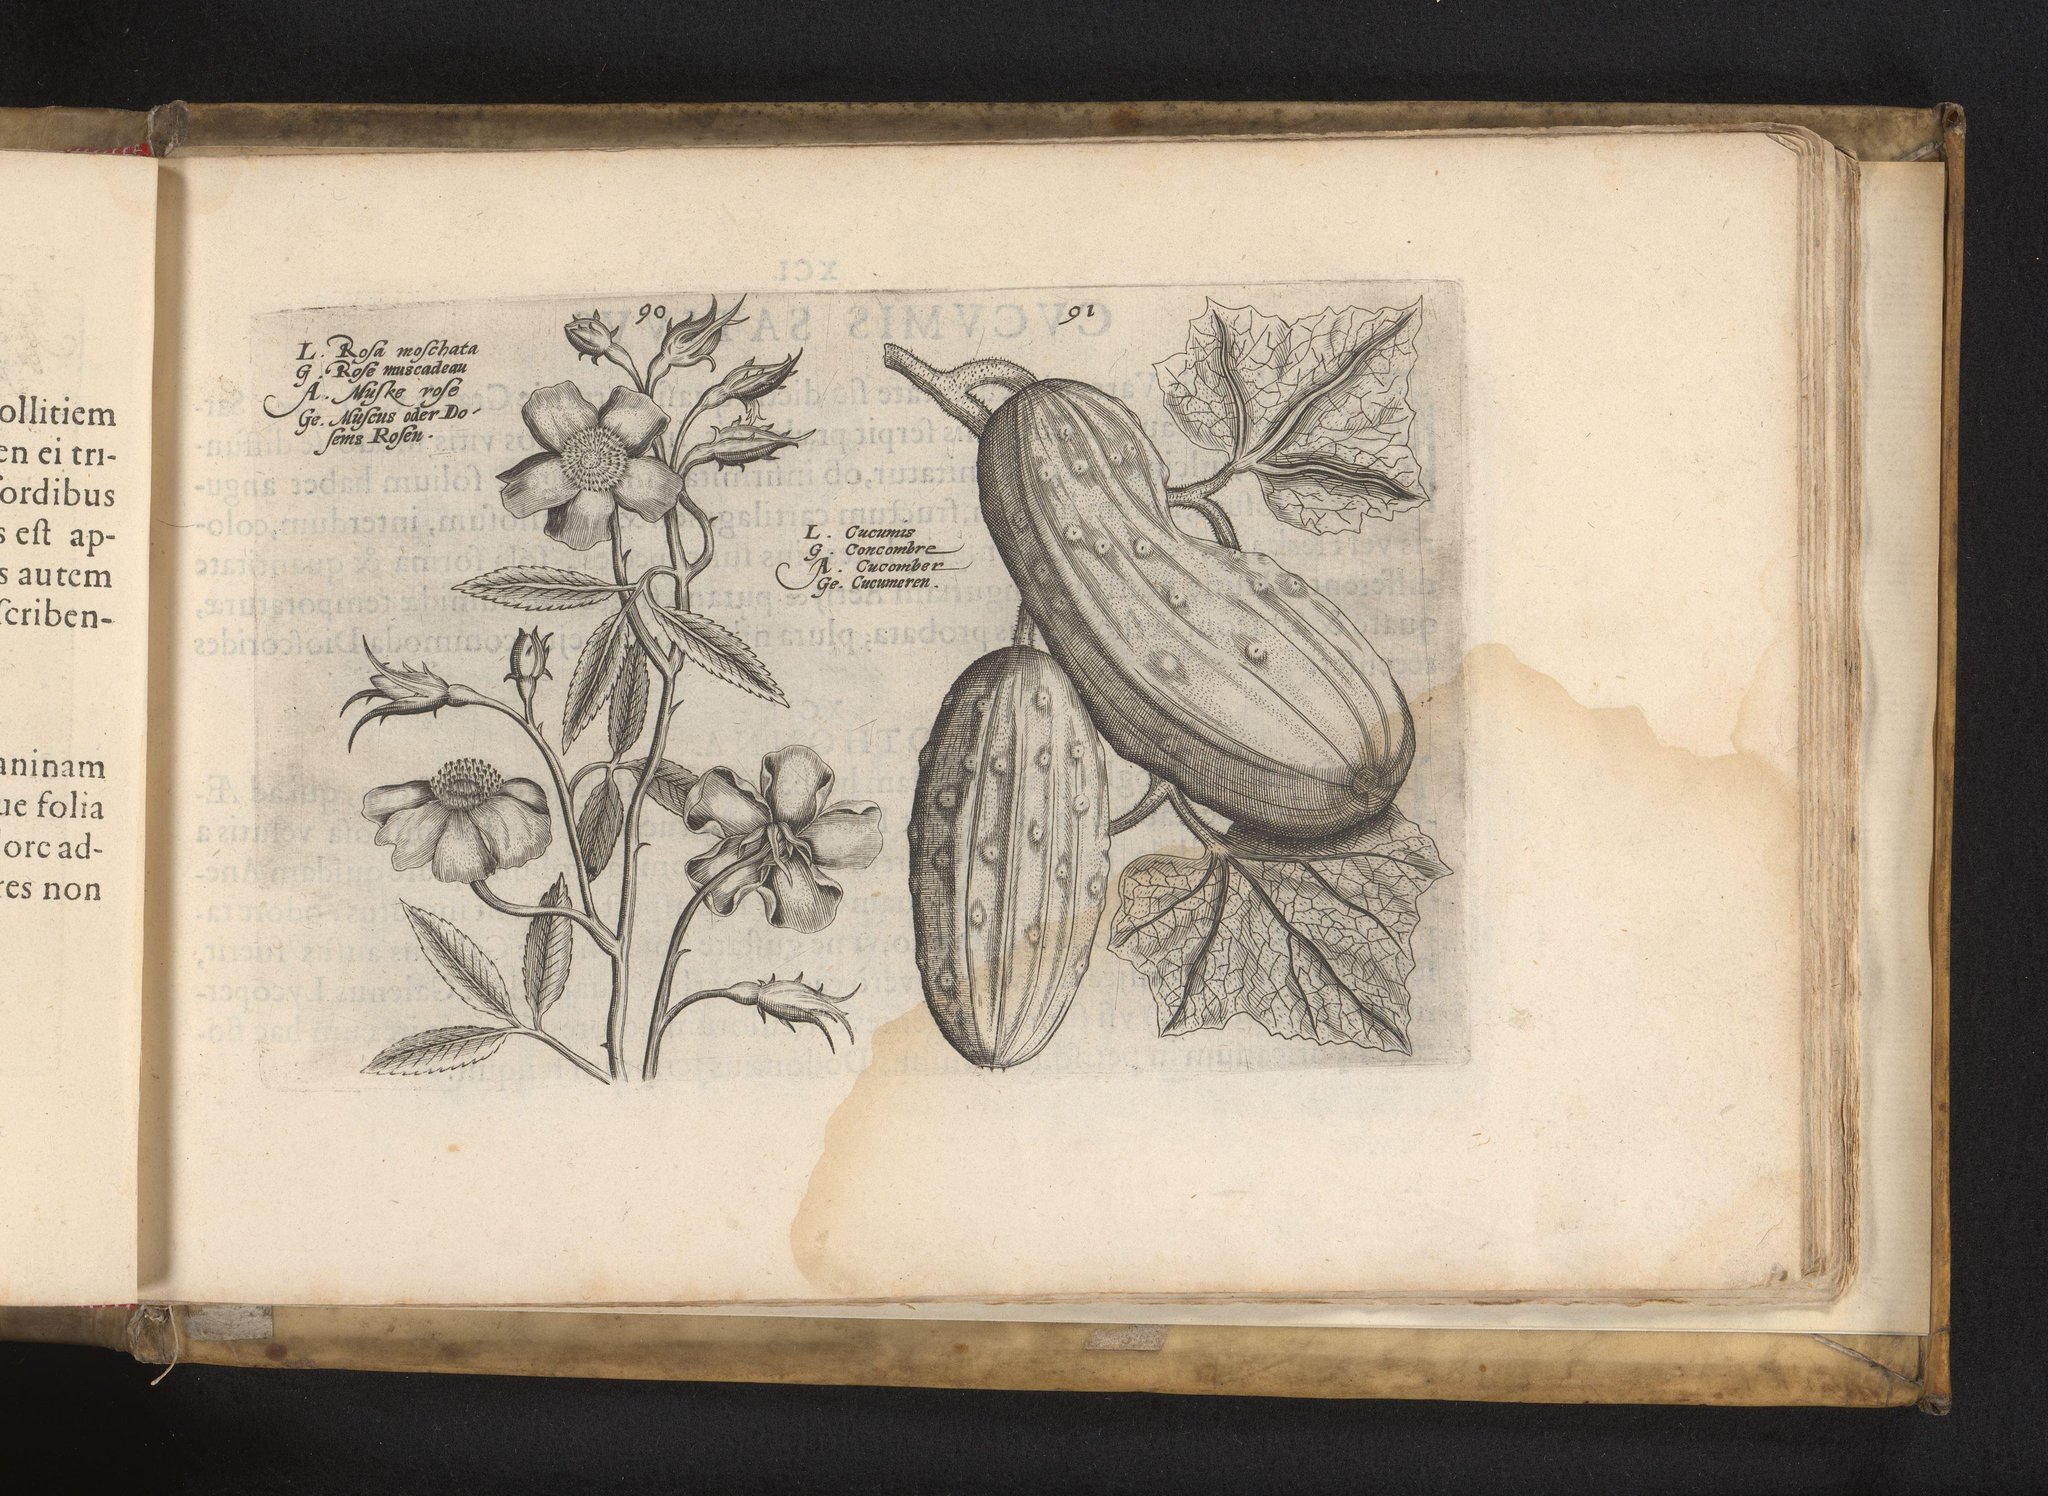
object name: book illustration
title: Bloementuin, het andere deel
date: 1617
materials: paper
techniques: engraving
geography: arnhem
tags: flowers, vegetables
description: Prent uit: Passe, Crispijn van de (II). Hortus floridus in quo rariorum & minus vulgarium florum icones ad vivam veramque formam. Arnhem: Johannes Janssonius, 1617.